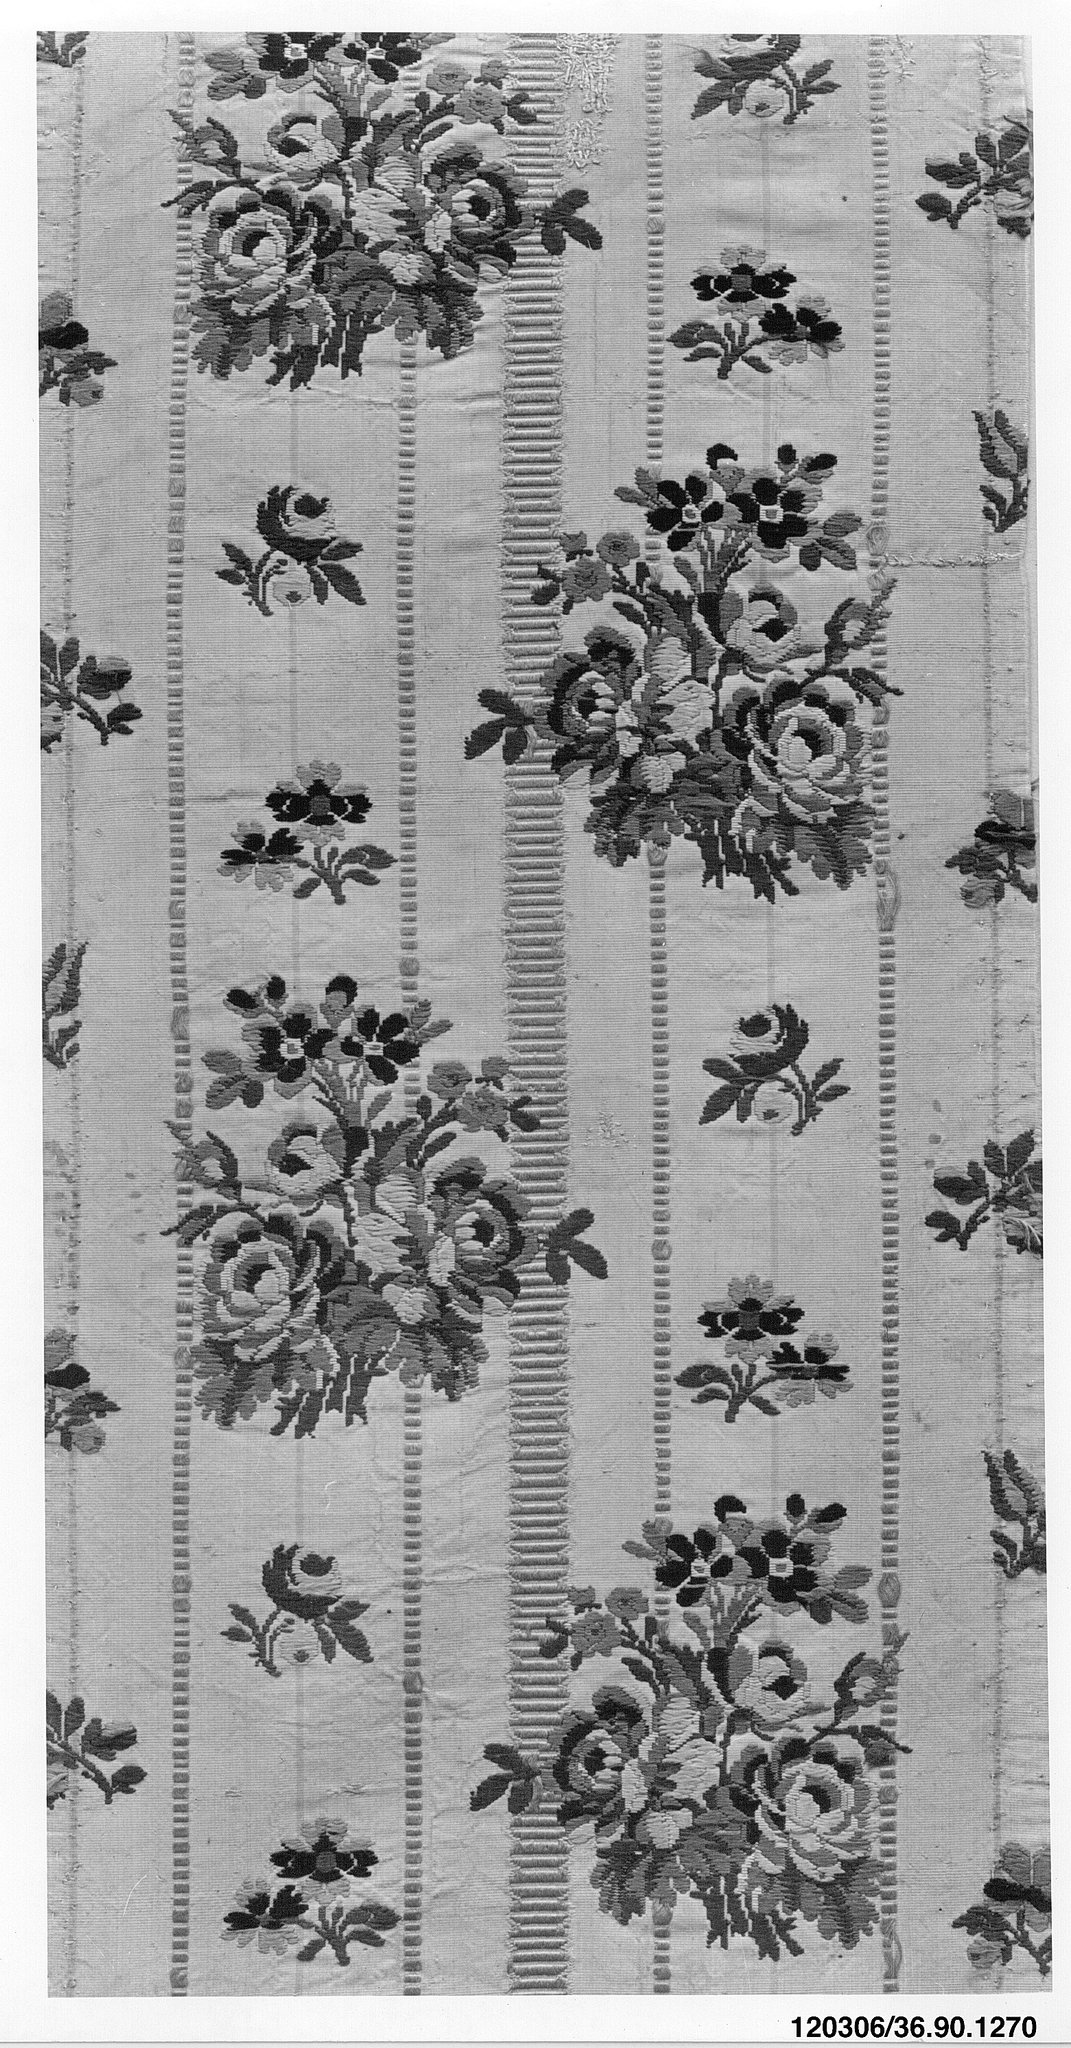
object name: piece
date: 1701-1800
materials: silk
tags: flowers